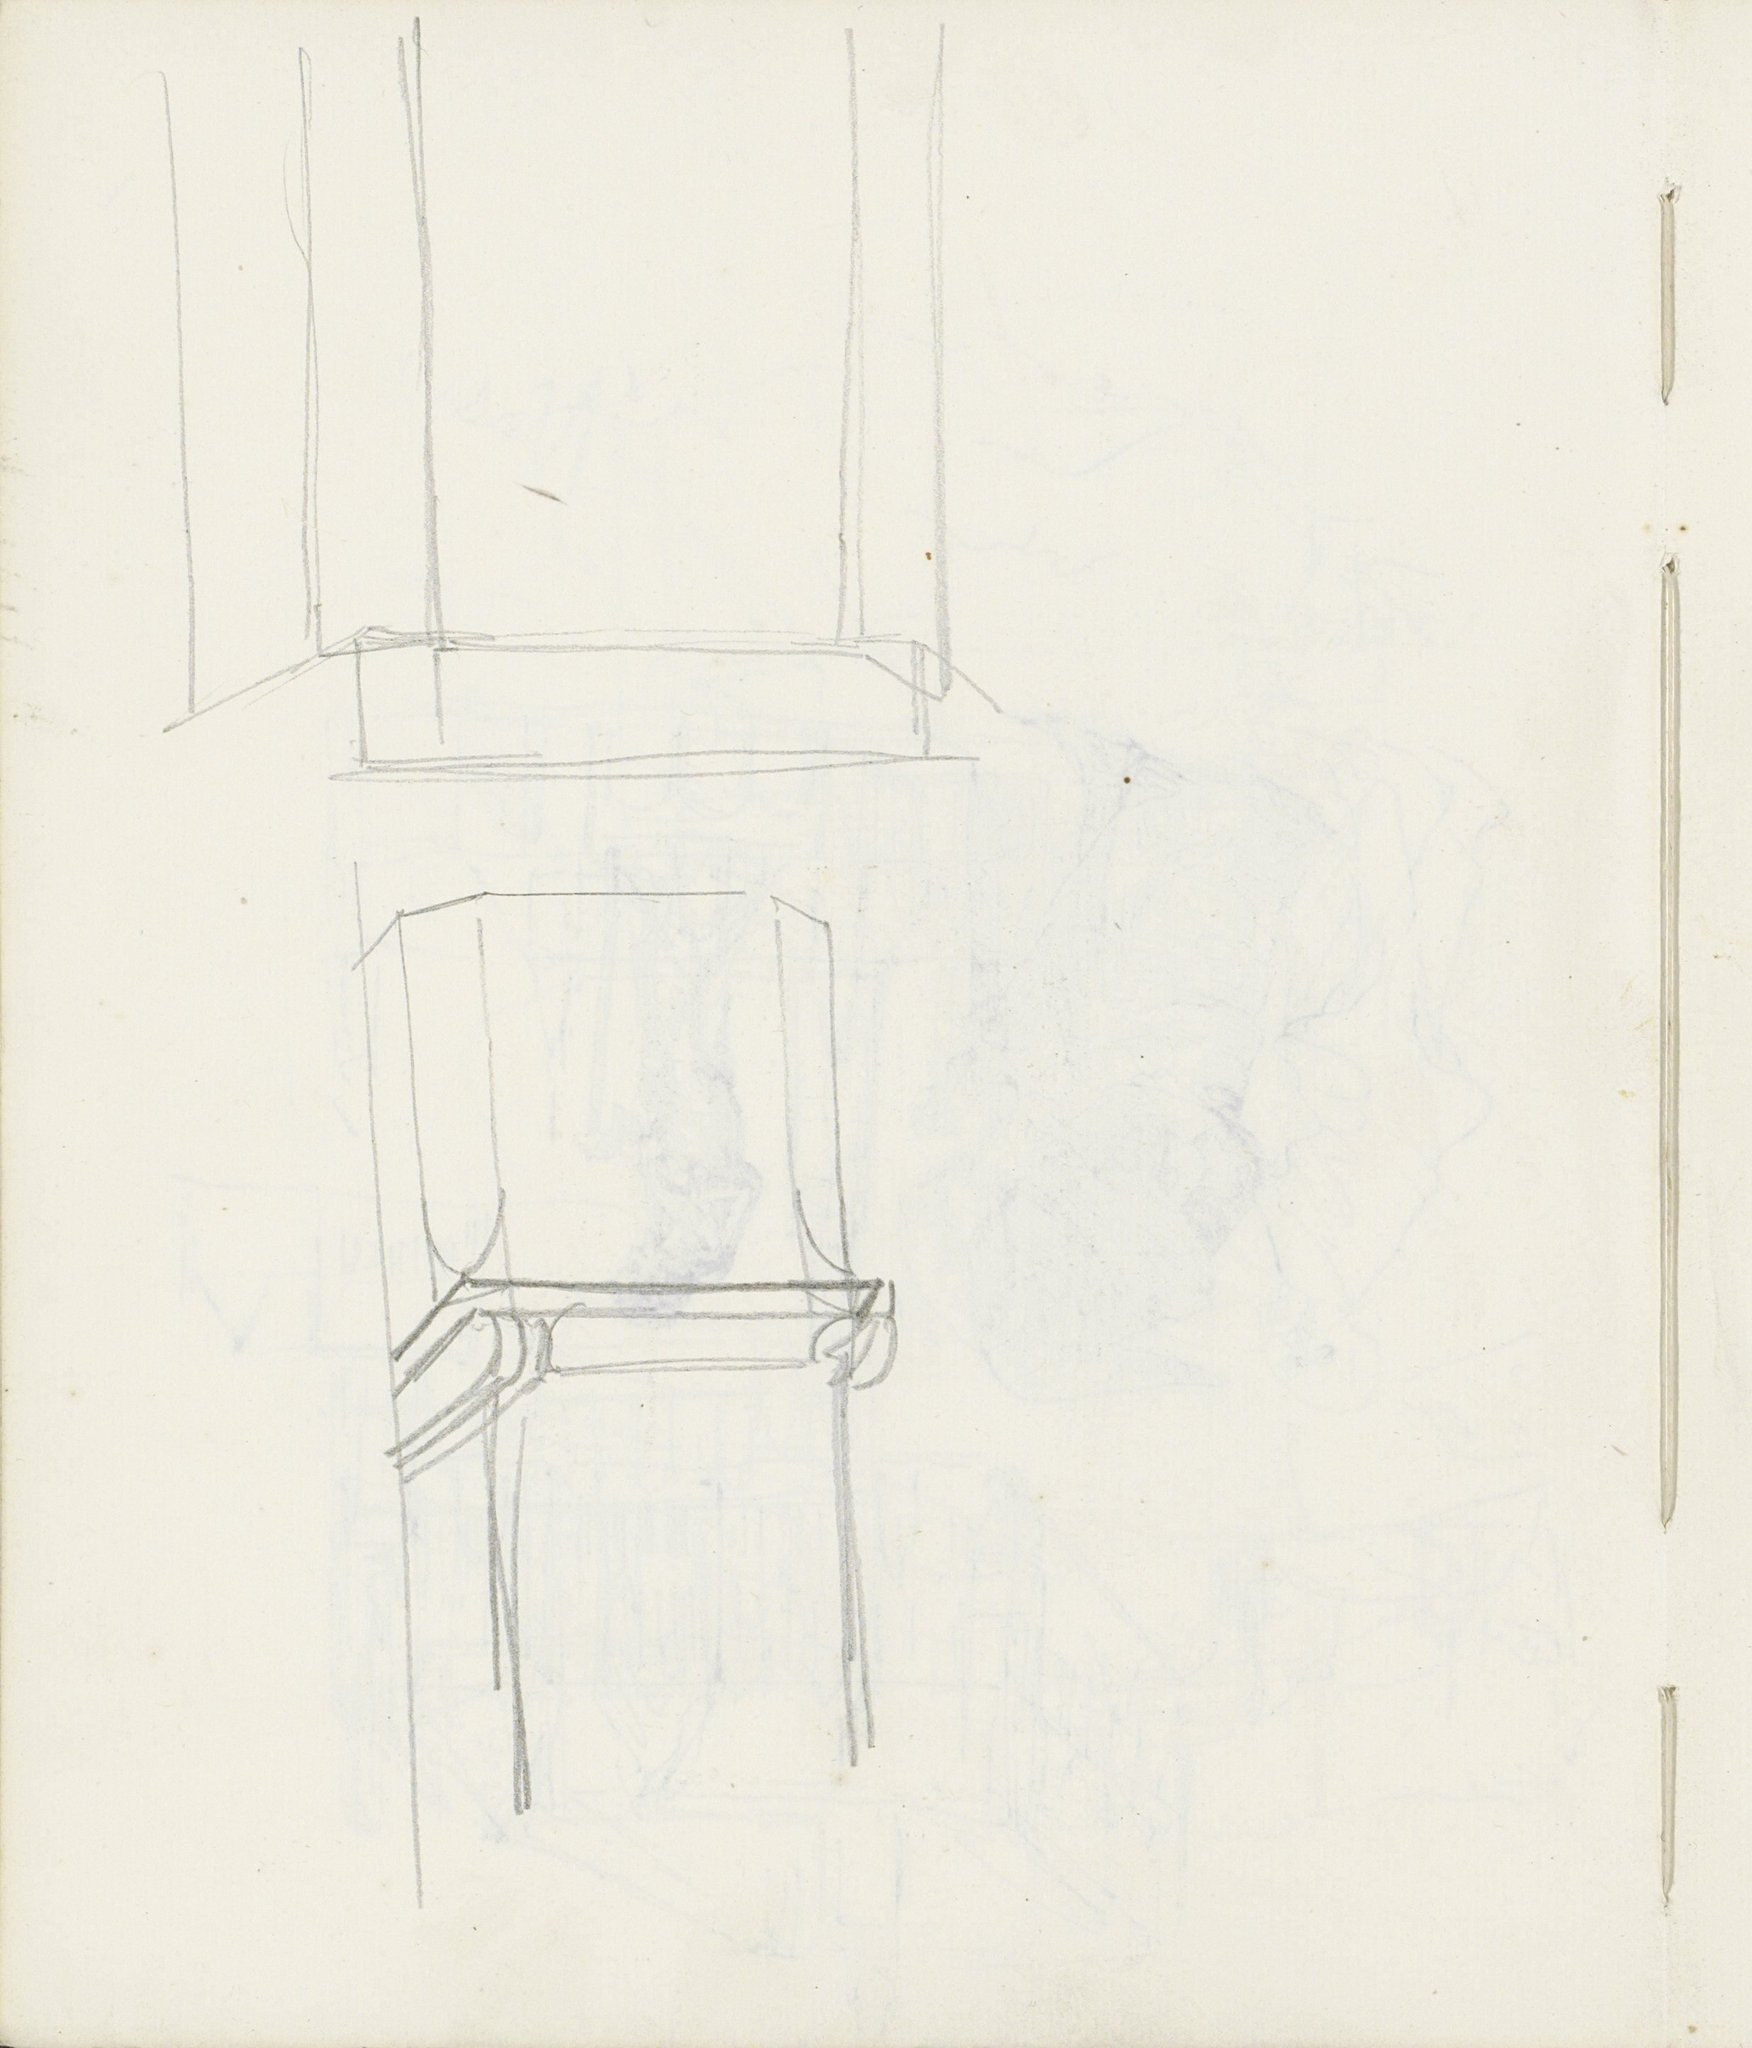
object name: sketchbook leaf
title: Ontwerp voor een meubelstuk of architectuur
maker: carel adolph lion cachet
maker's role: draughtsman, print maker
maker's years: 1864-1945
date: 1900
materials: paper, pencil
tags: architecture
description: Blad 4 verso uit een schetsboek met 15 bladen.